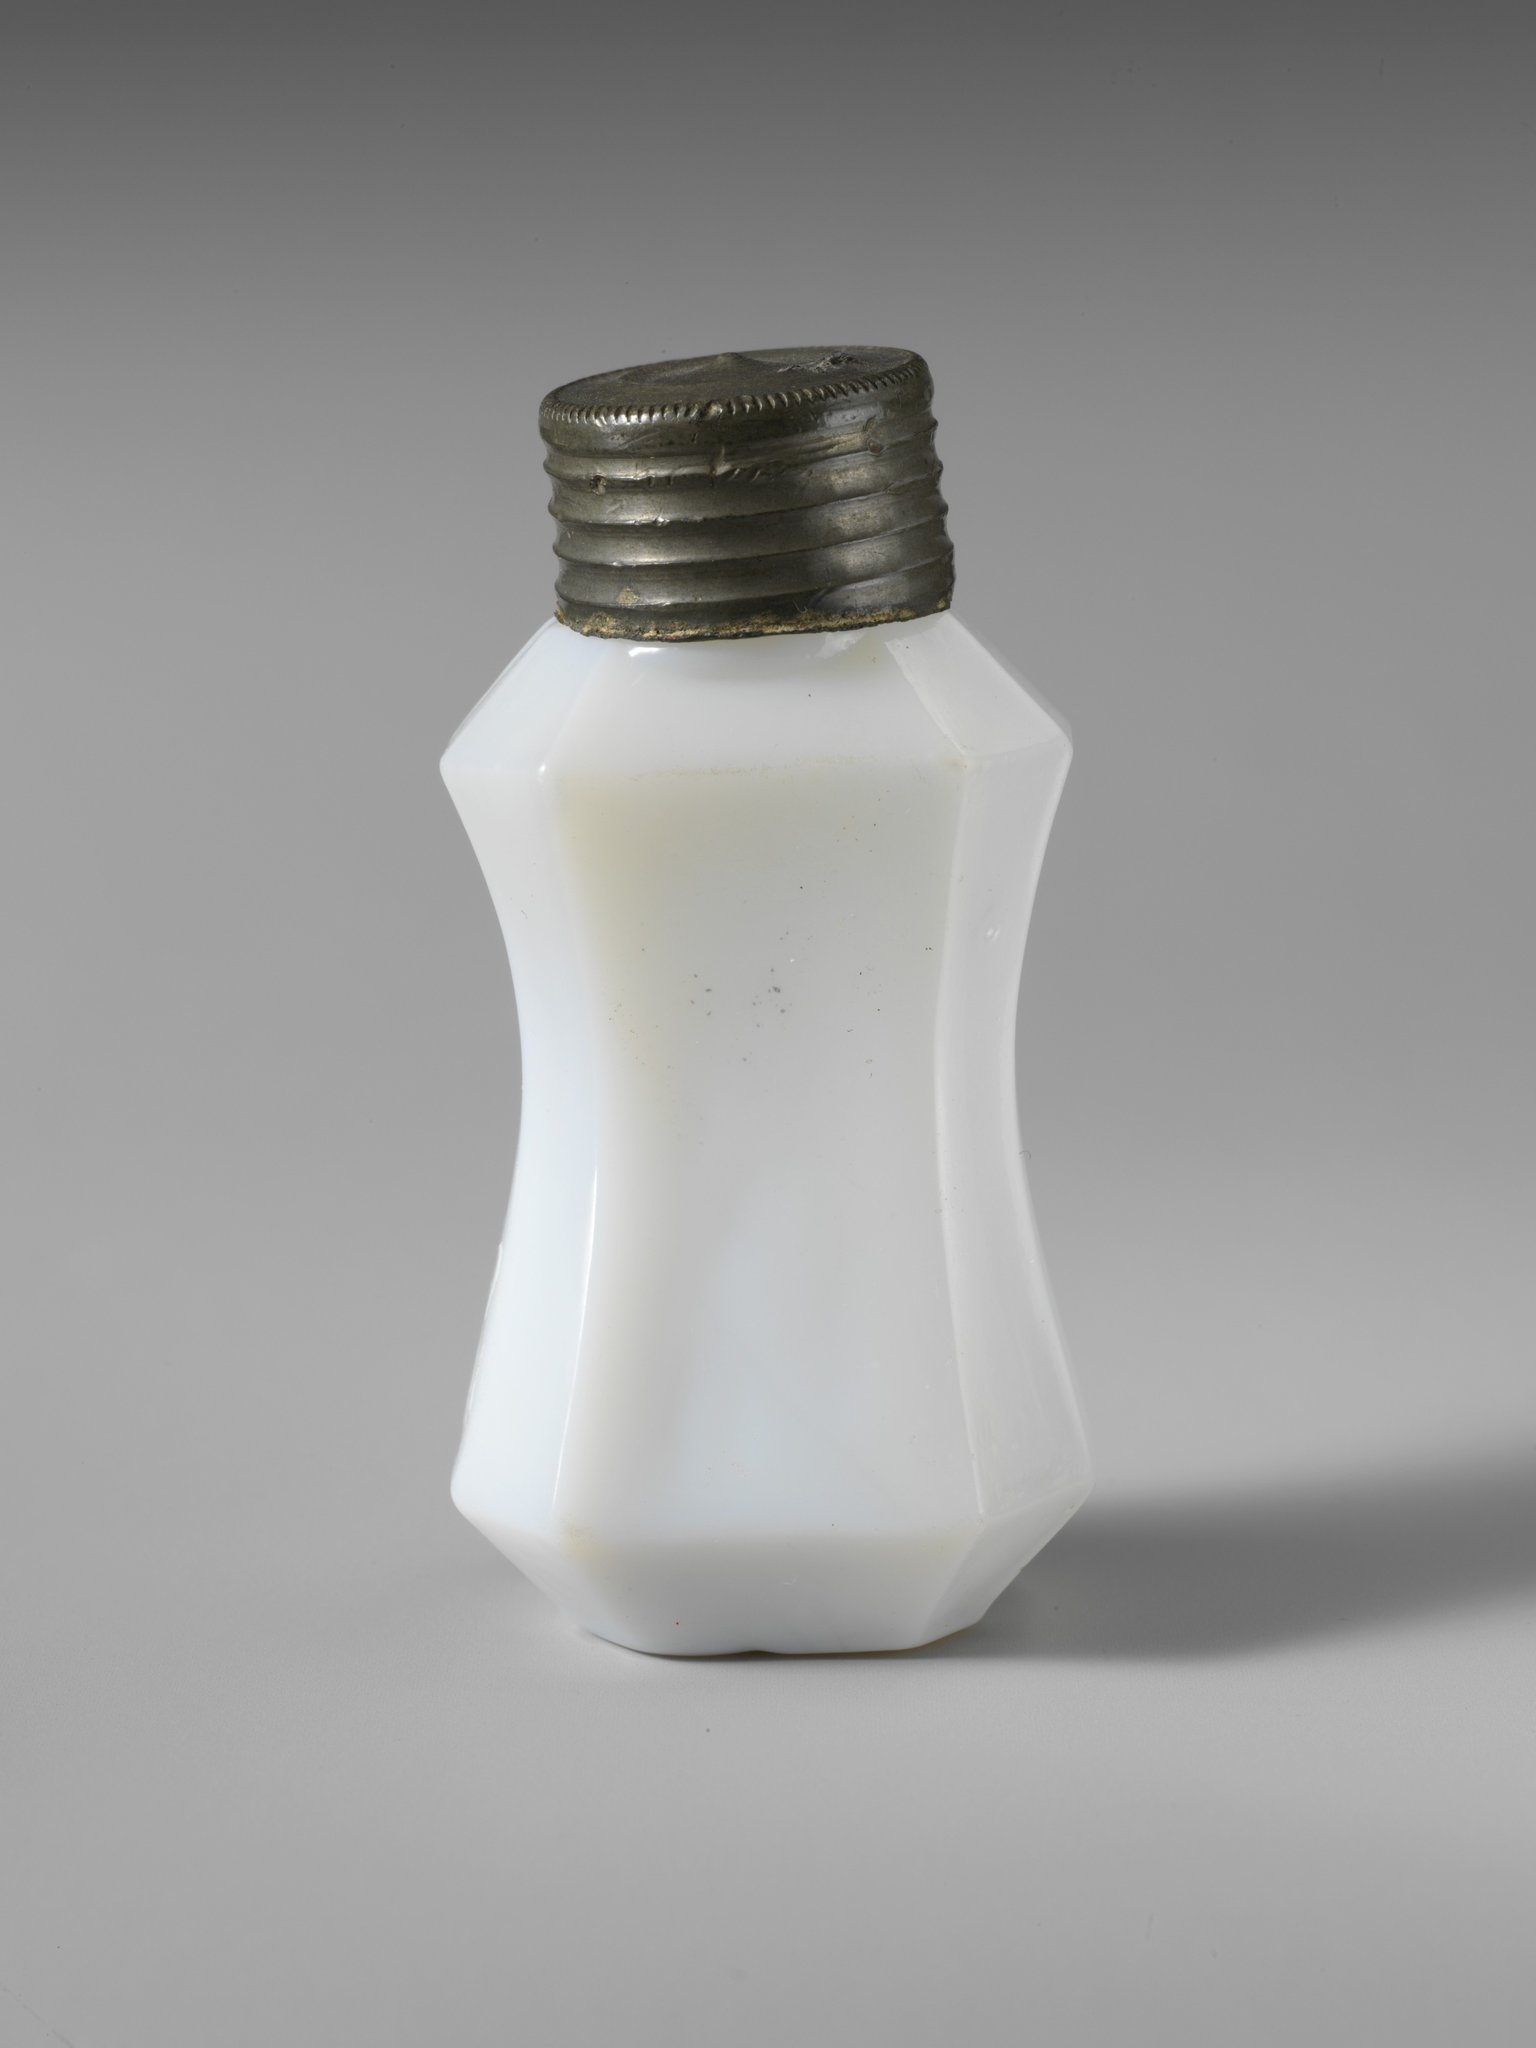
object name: bottle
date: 1850-1900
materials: glass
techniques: pressed